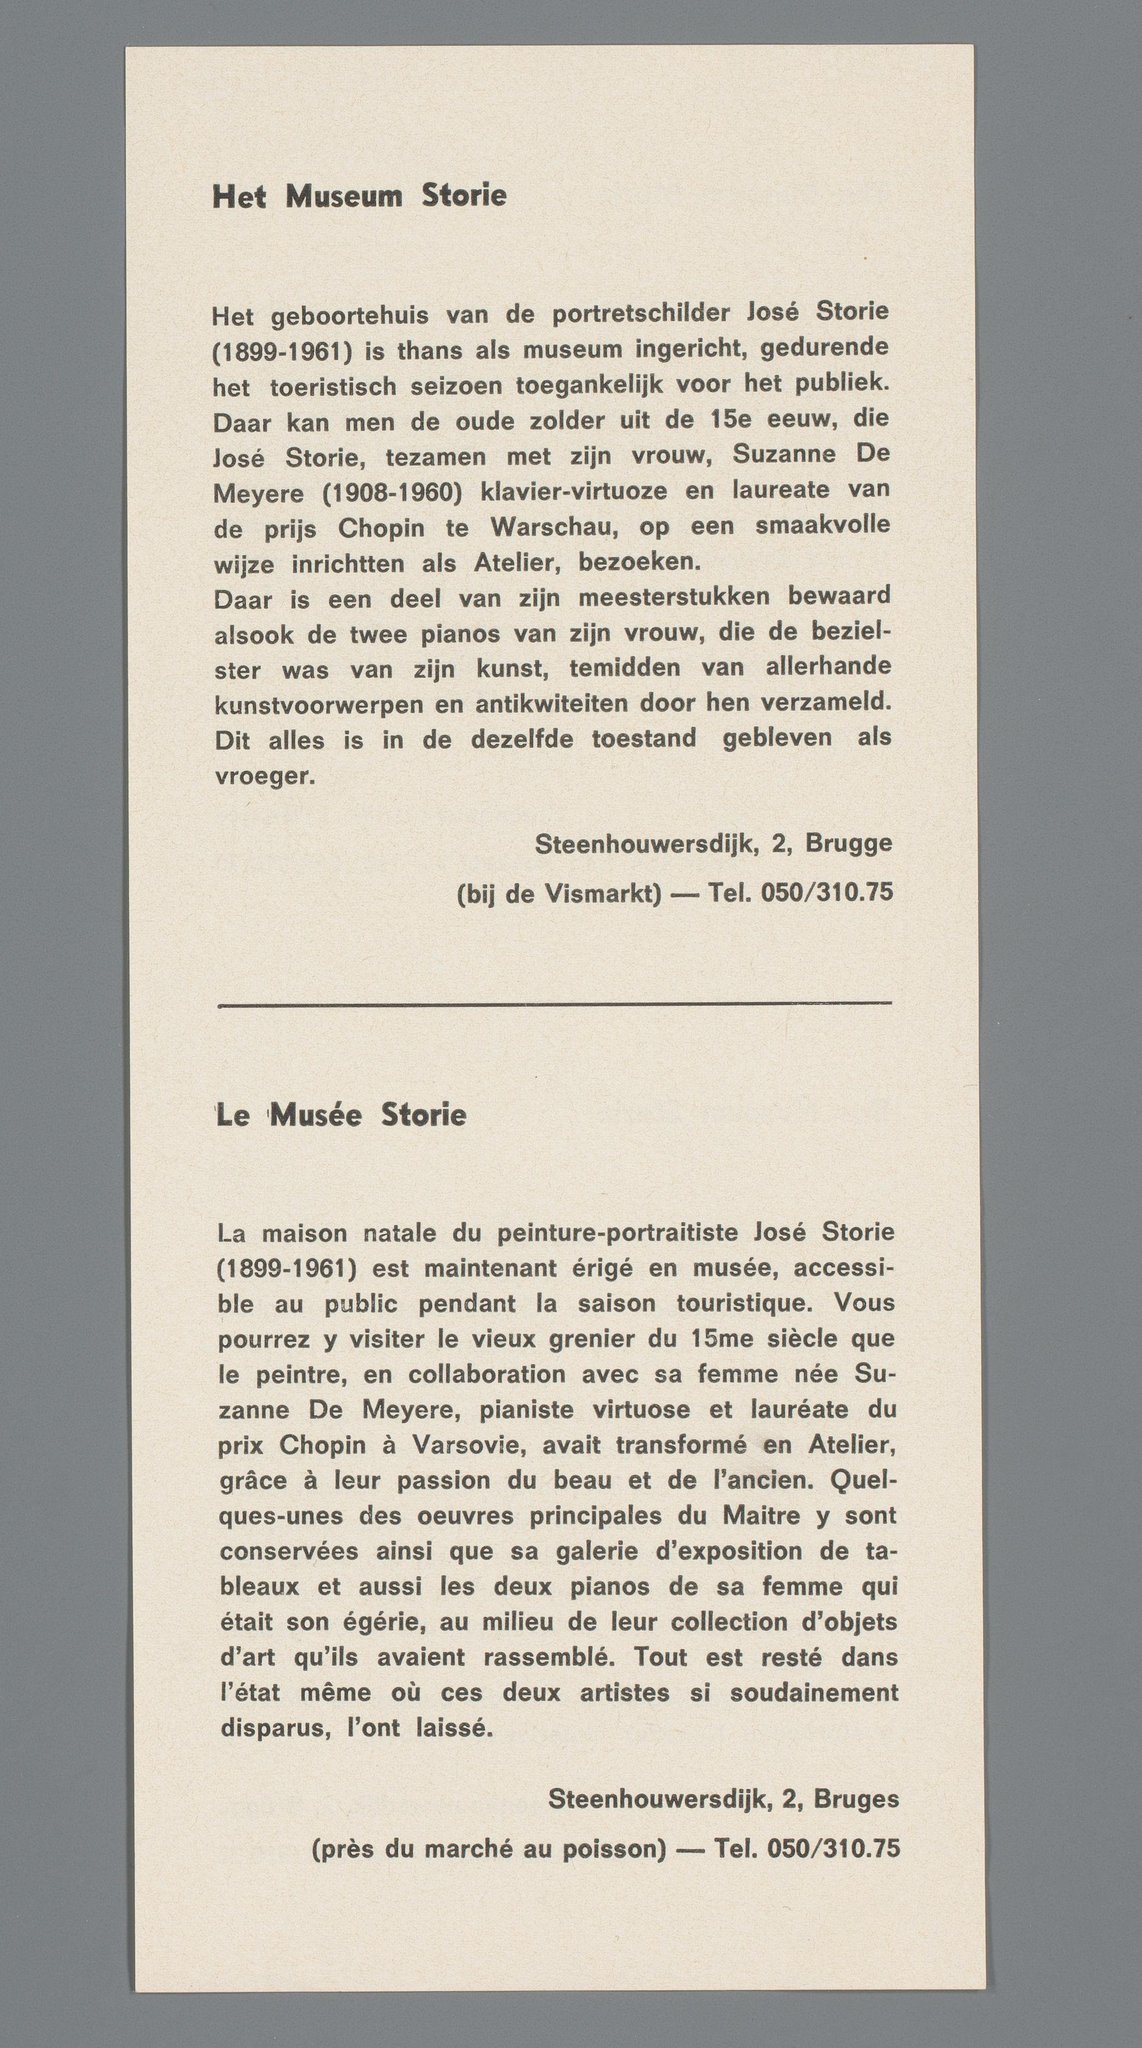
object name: document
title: Folder van Museum Storie in Brugge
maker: Anonymous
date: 1968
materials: paper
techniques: letterpress printing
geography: bruges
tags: permanent exhibition, museum, bruges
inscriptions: inscription: ‘Het geboortehuis van de portretschilder José Storie/ (1899-1961) is thans als museum ingericht, gedurende/ het toeristisch seizoen toegankelijk (...)’, address: ‘Steenhouwersdijk, 2, Brugge/ (bij de Vismarkt) - Tel. 050/310.75’